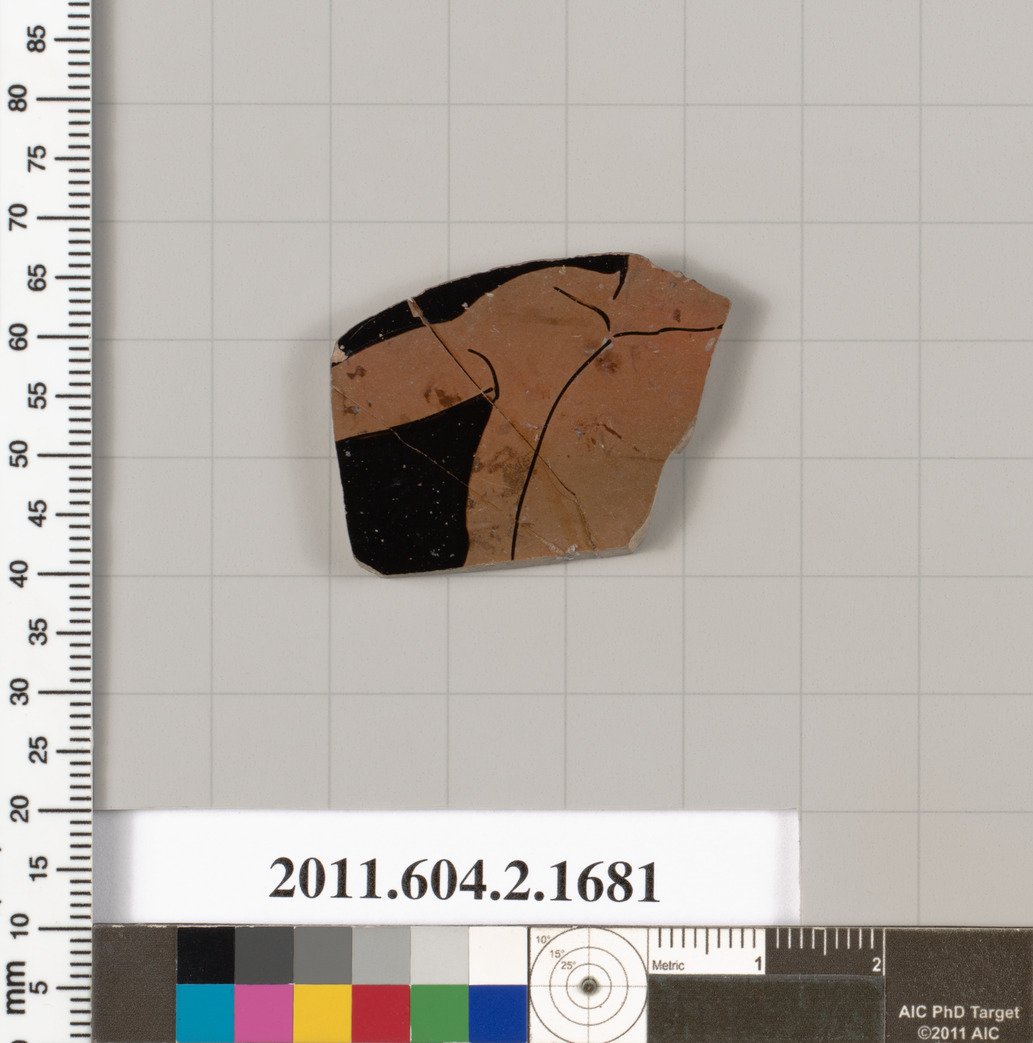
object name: skyphos fragment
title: Terracotta fragment of a skyphos (deep drinking cup)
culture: greek, attic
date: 480-470 BCE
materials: terracotta